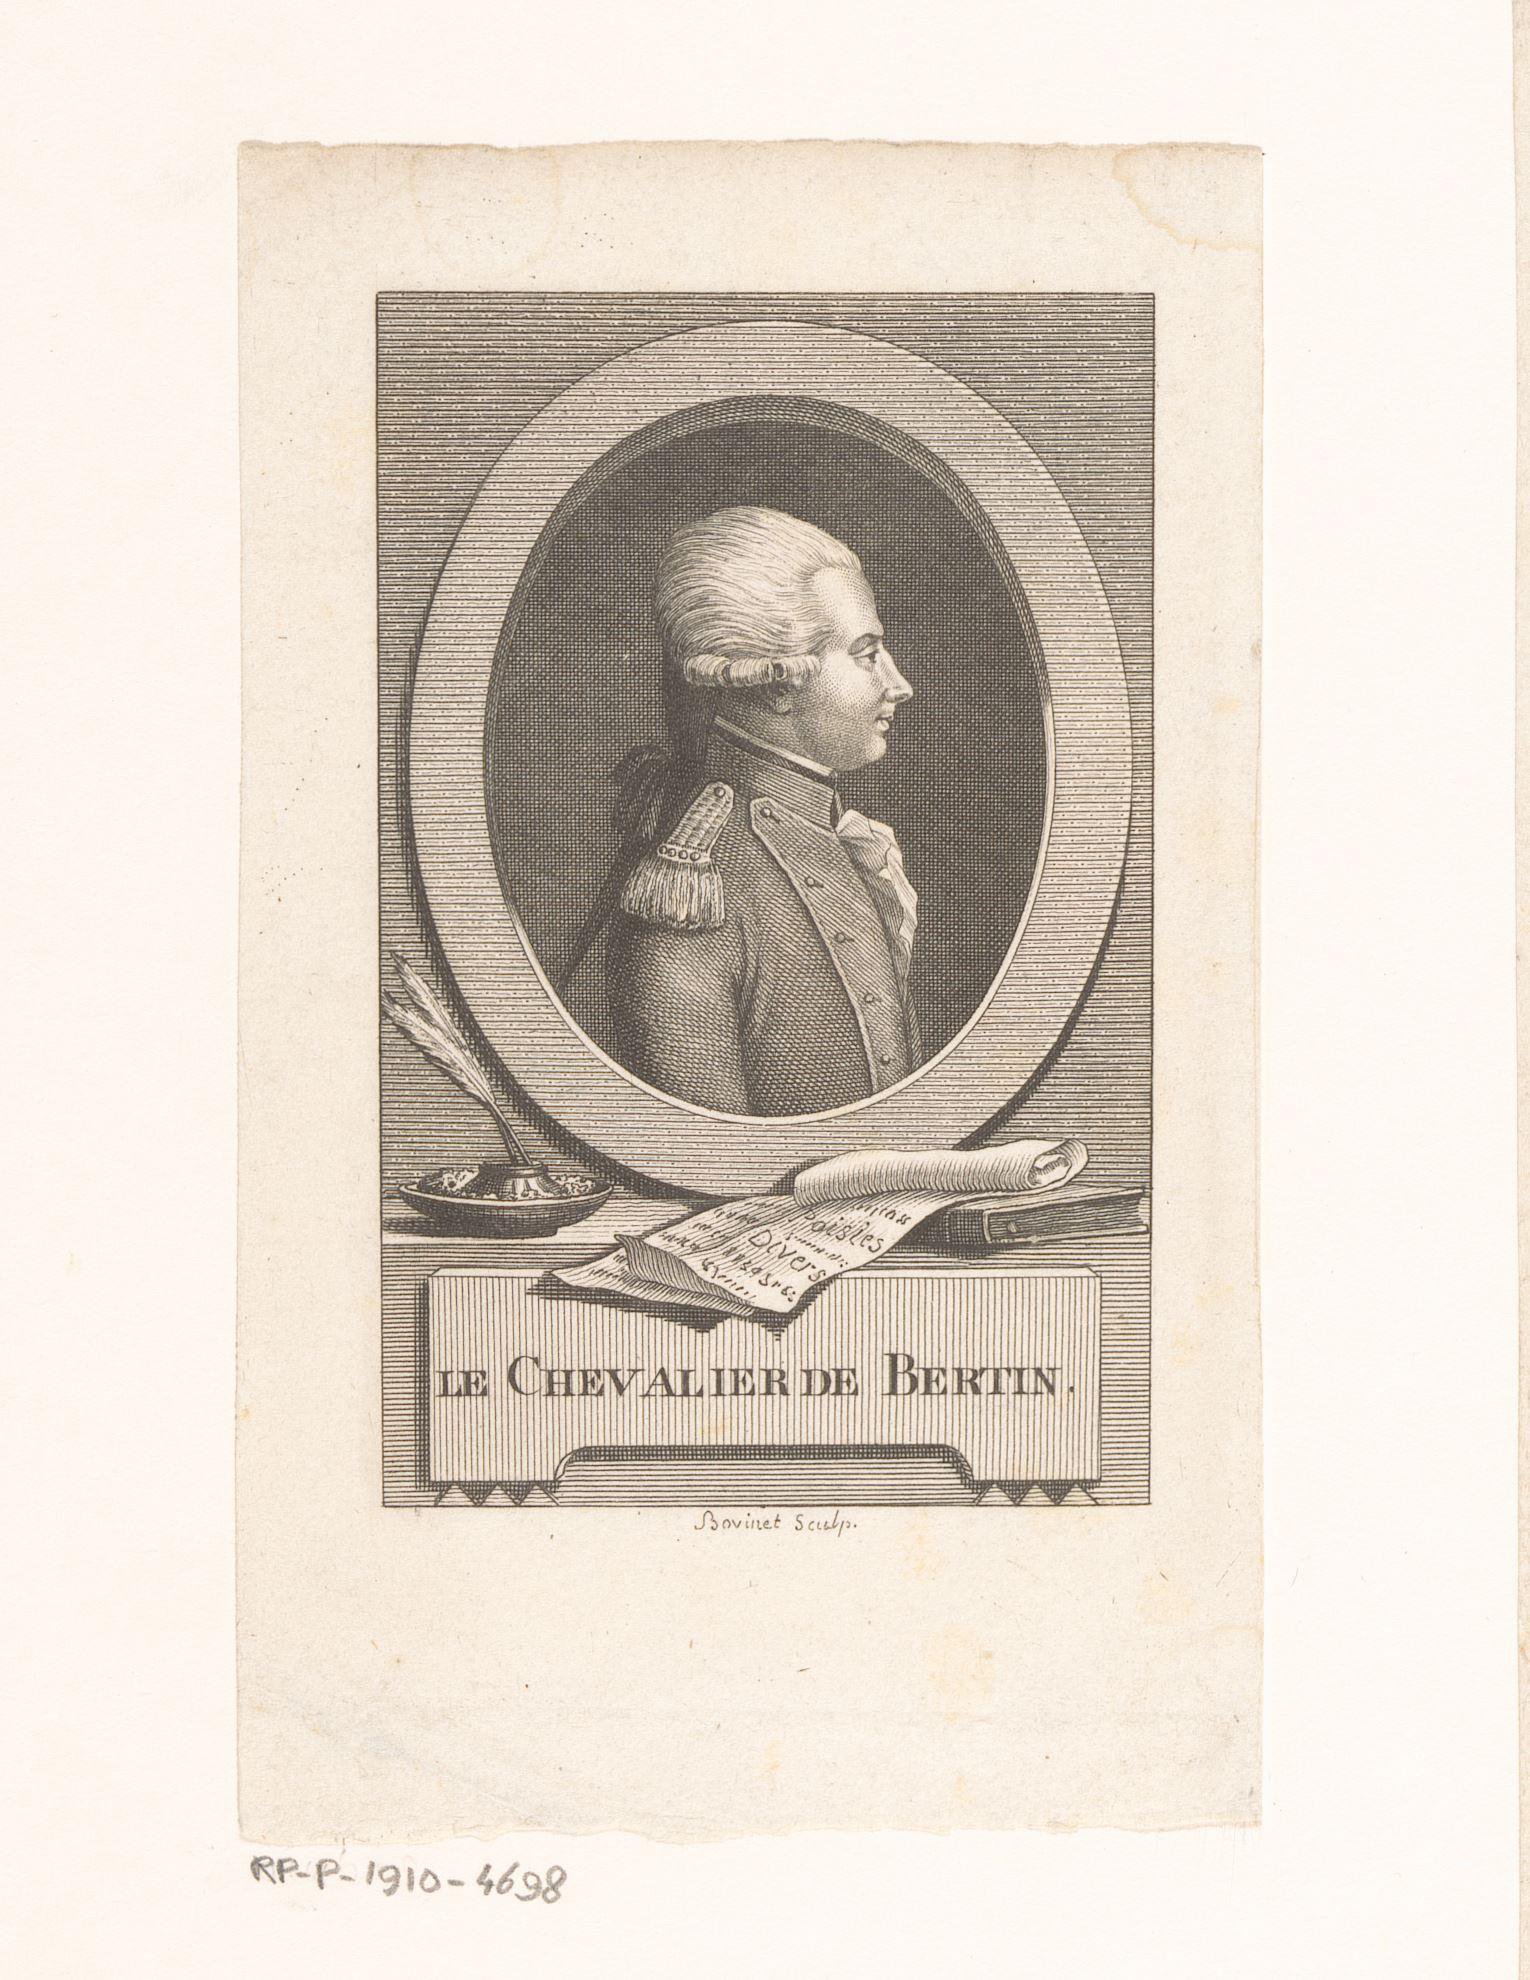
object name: print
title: Le Chevalier de Bertin.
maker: edme bovinet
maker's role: print maker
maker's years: 1767-1832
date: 1777-1832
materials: paper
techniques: etching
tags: historical persons, portrait of a writer, writer, poet, author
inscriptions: collector's mark: Lugt 2228